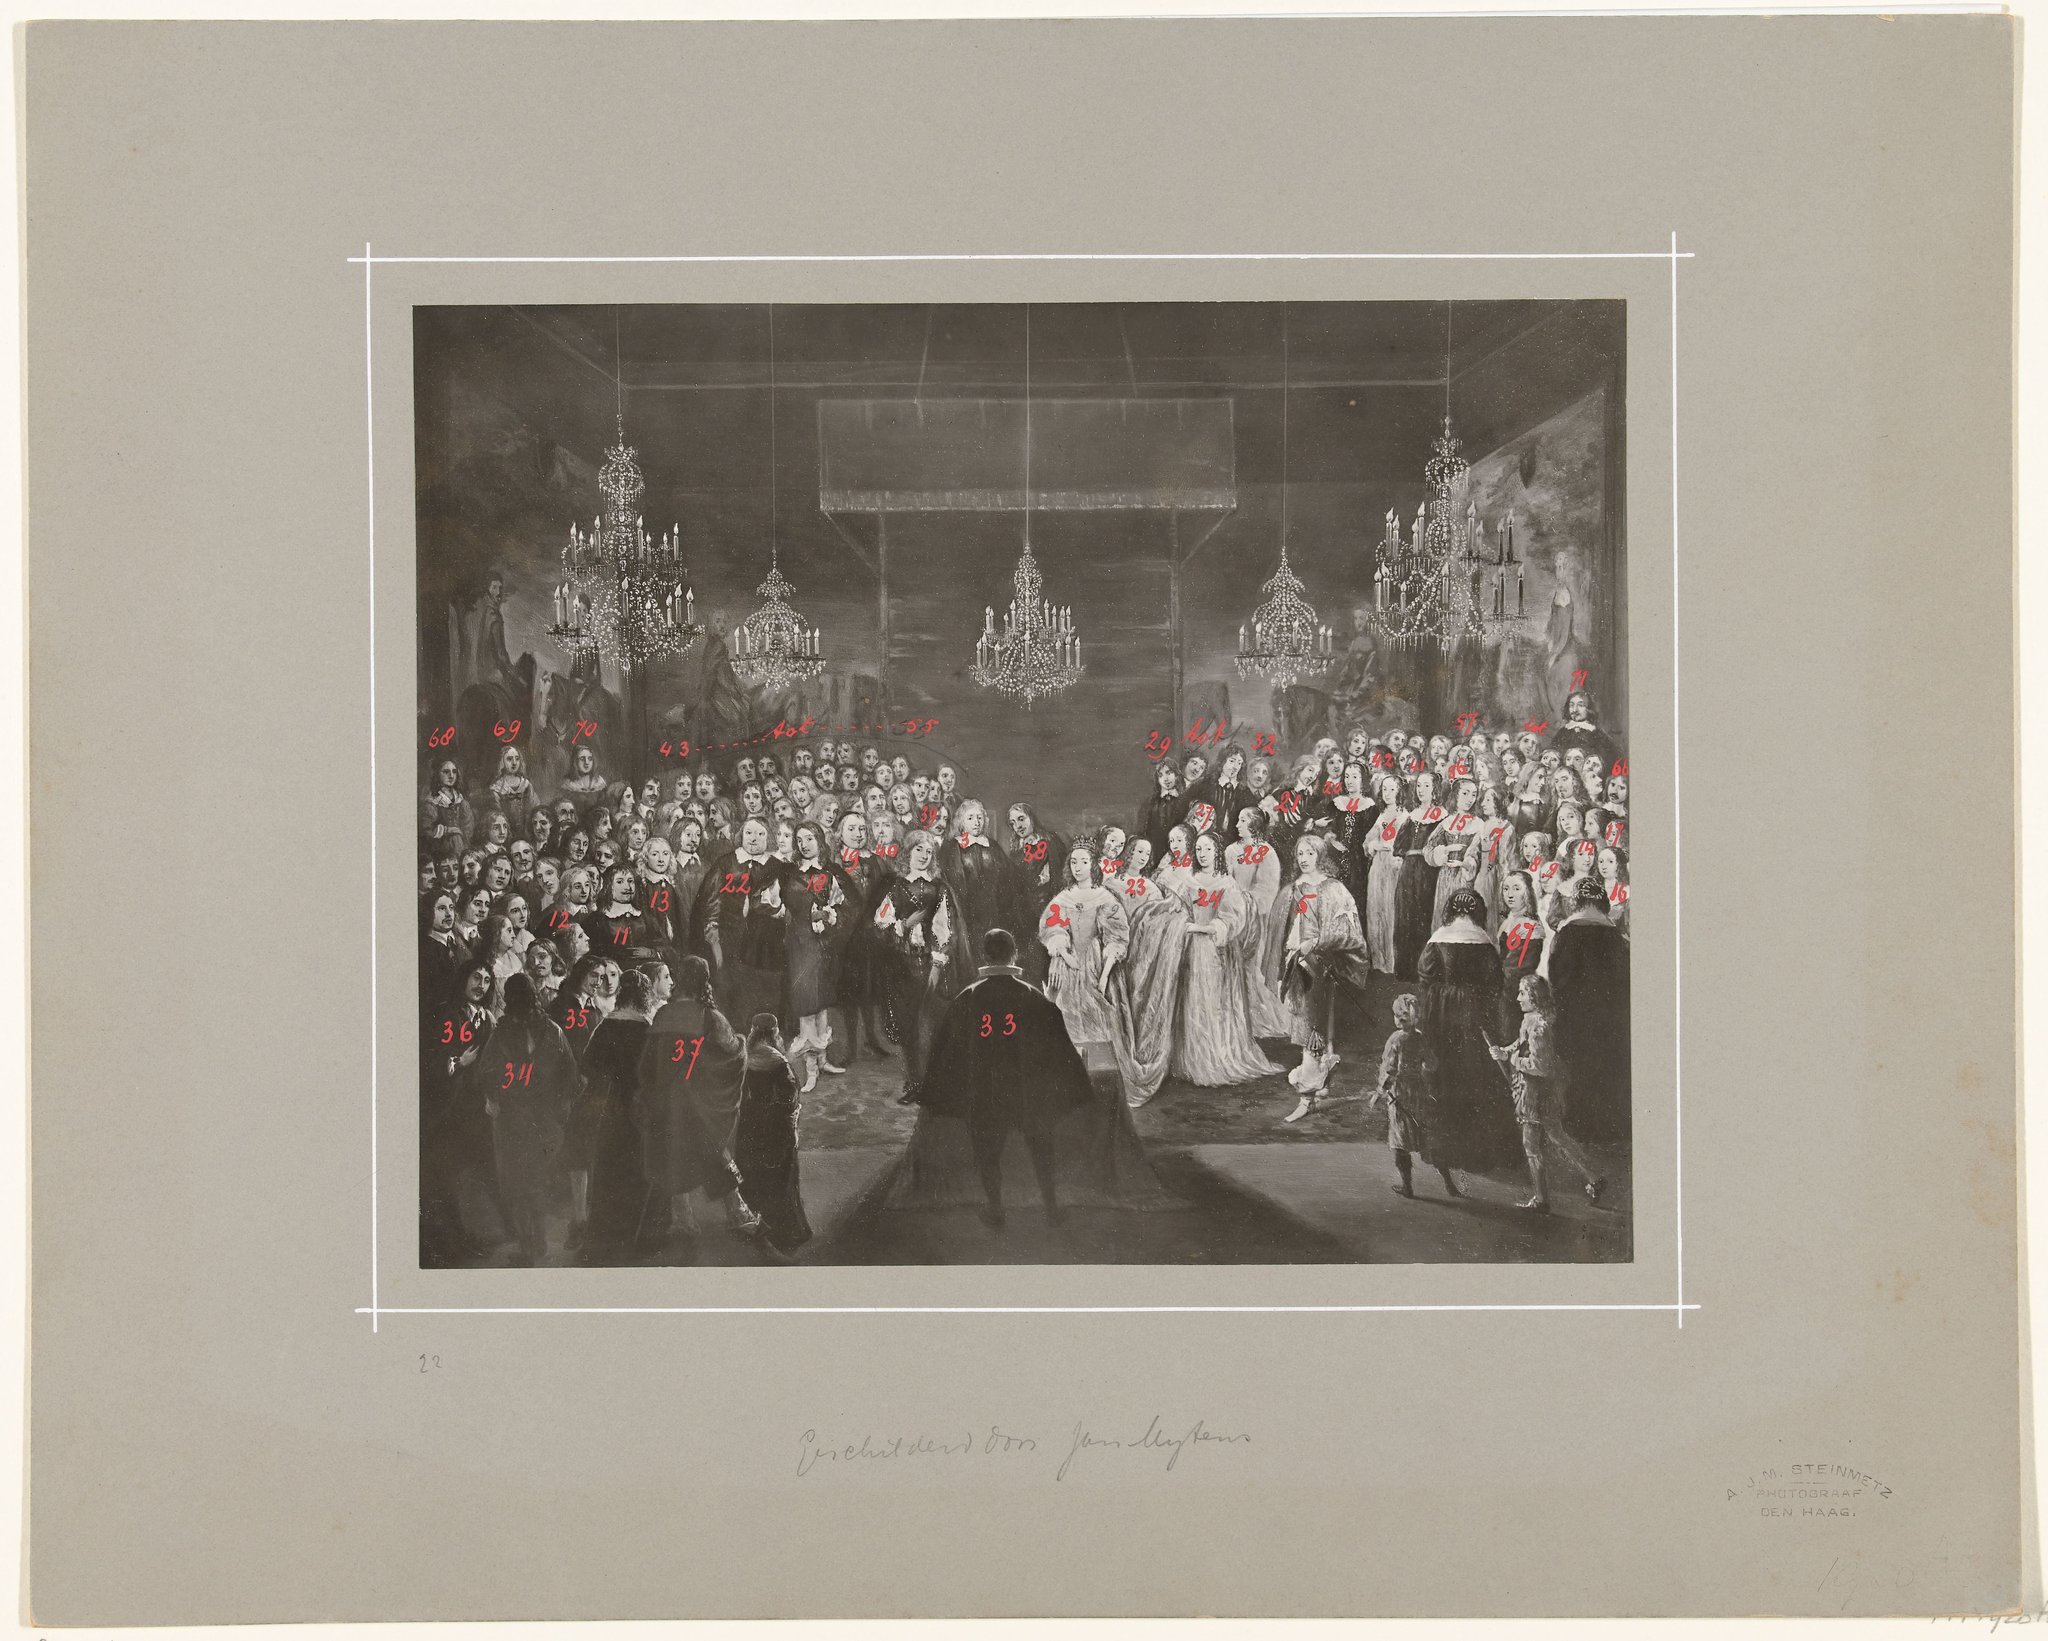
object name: photograph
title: Huwelijk van prinses Louise Henriëtte met Frederik Willem, keurvorst van Brandenburg, 1646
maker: antoine johan marinus steinmetz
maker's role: fotograaf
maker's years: 1867-1950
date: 1903-1931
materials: cardboard, paper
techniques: photography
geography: the hague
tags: frederik willem van brandenburg (i), louise henriëtte (prinses van oranje), (civil) marriage ceremonies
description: Het huwelijk van prinses Louise Henriëtte, prinses van Oranje met Frederik Willem, keurvorst van Brandenburg, op 7 december 1646 in het Paleis Het Oude Hof (Paleis Noordeinde) te Den Haag. Foto van het schilderij van het huwelijk door Jan Mijtens waarop nummers met rode verf zijn geschreven bij alle afgebeelde personen. Bij deze foto behoort een lichtdruk met een legenda van de afgebeelde personen.